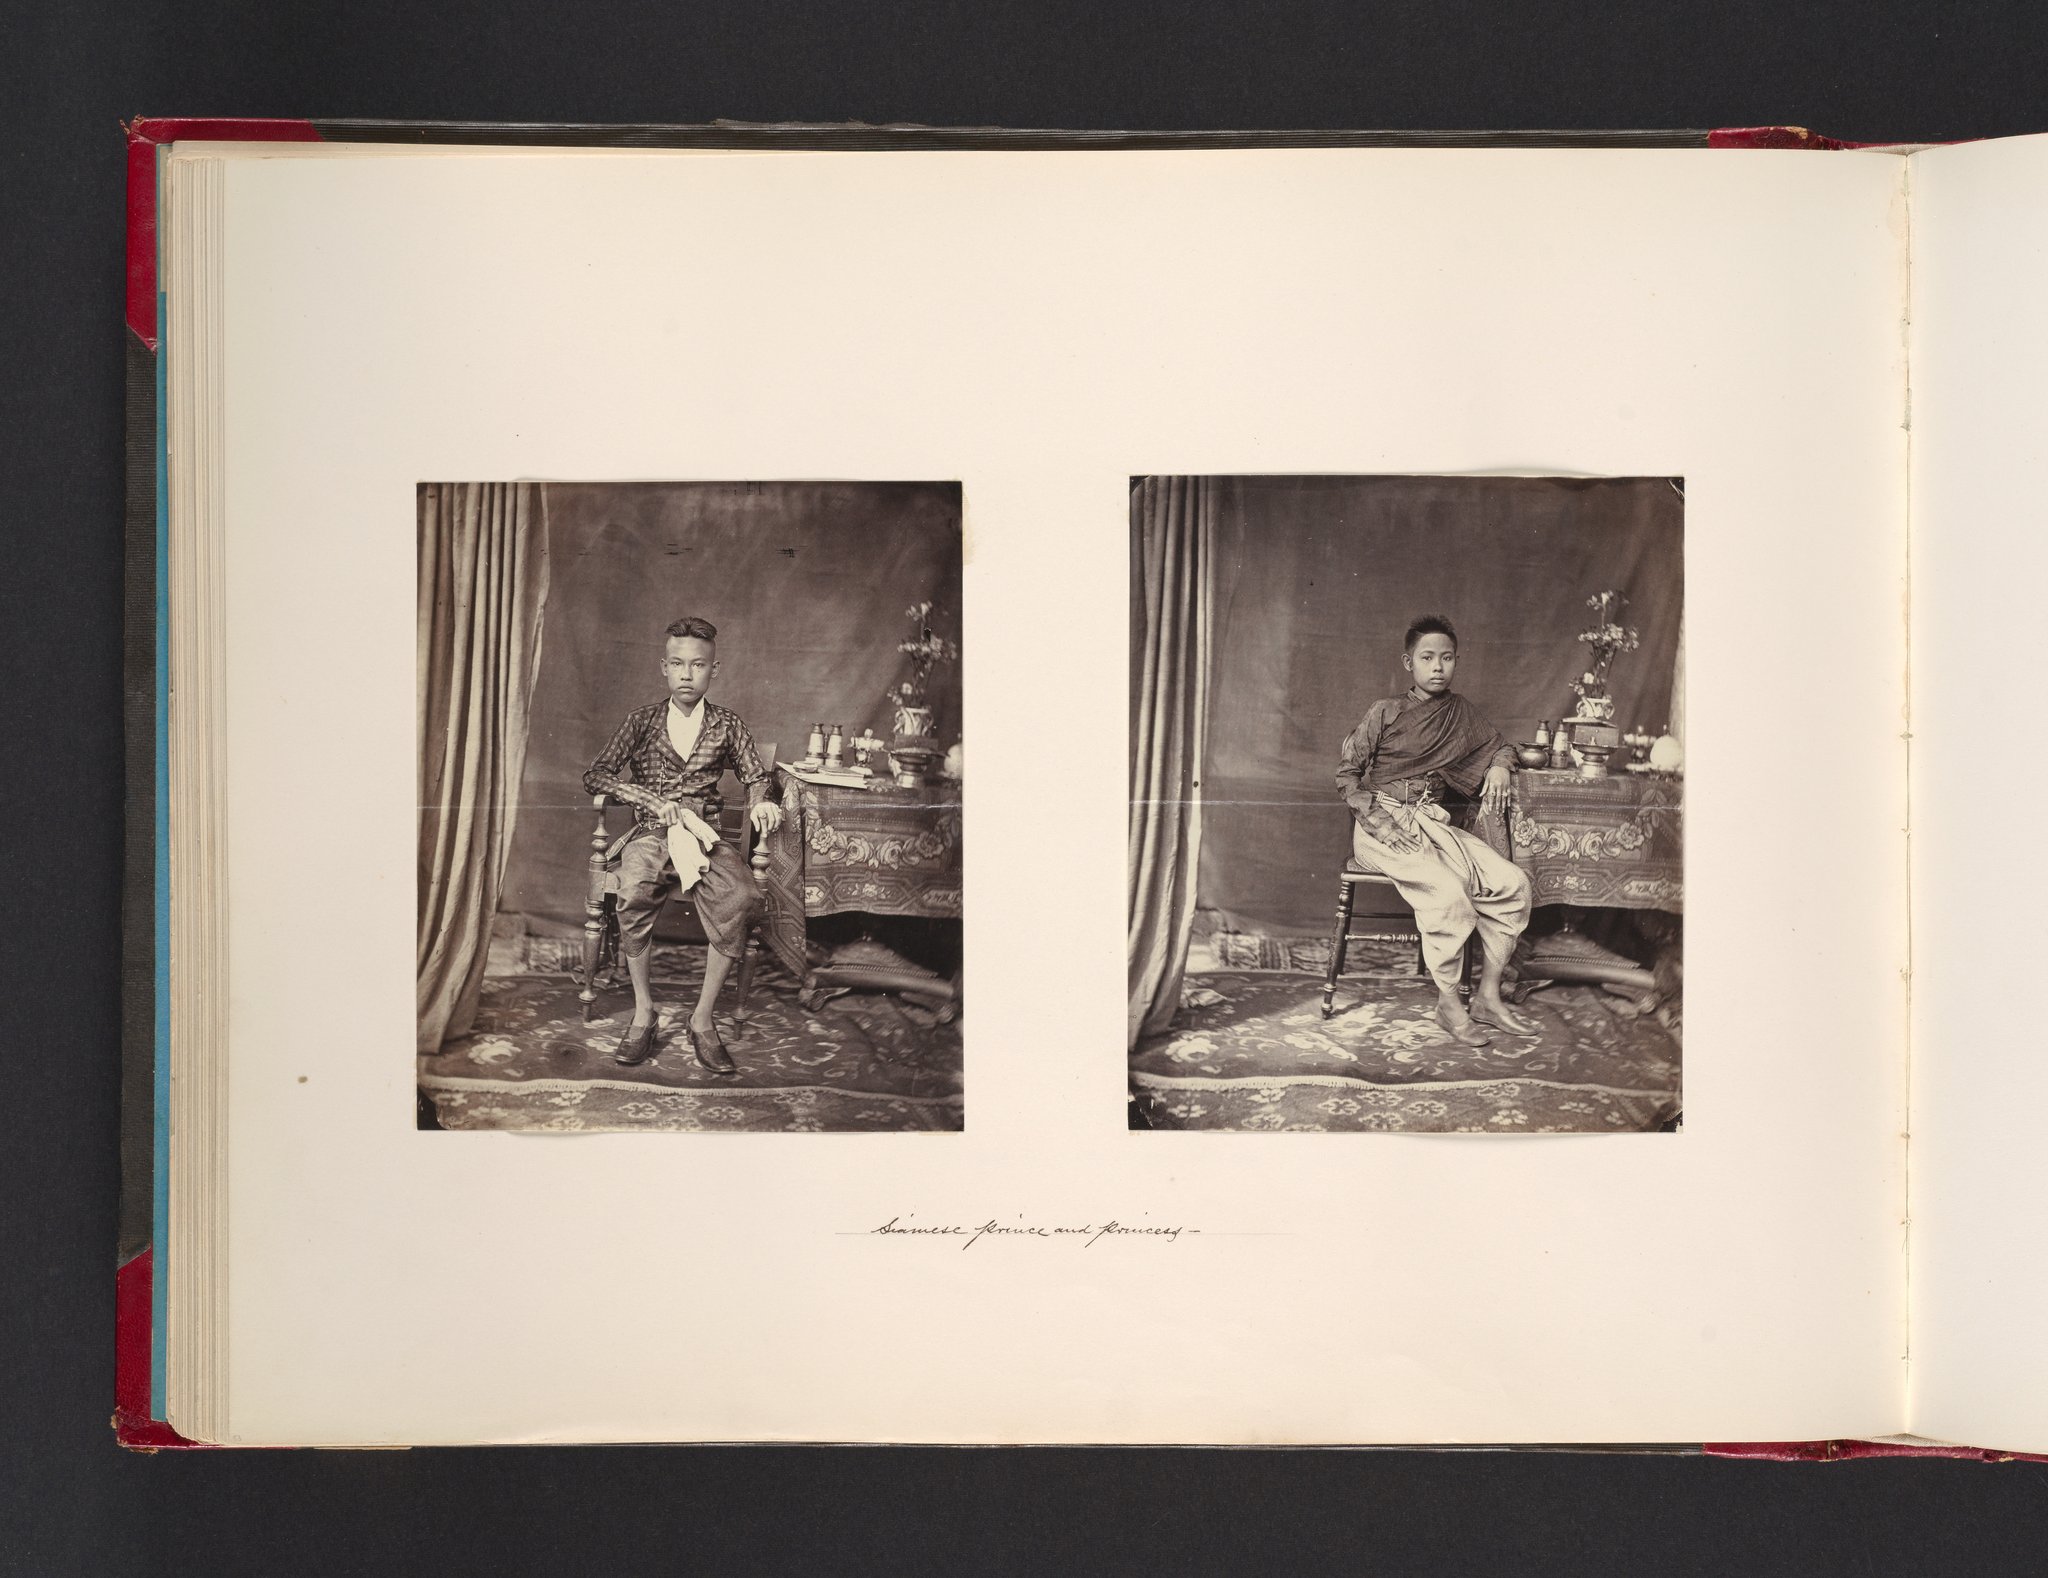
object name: photograph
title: Siamese Prince and Princess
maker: john thomson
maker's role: artist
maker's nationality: british, scottish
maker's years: 1837-1921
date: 1865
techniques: albumen silver print, glass negative